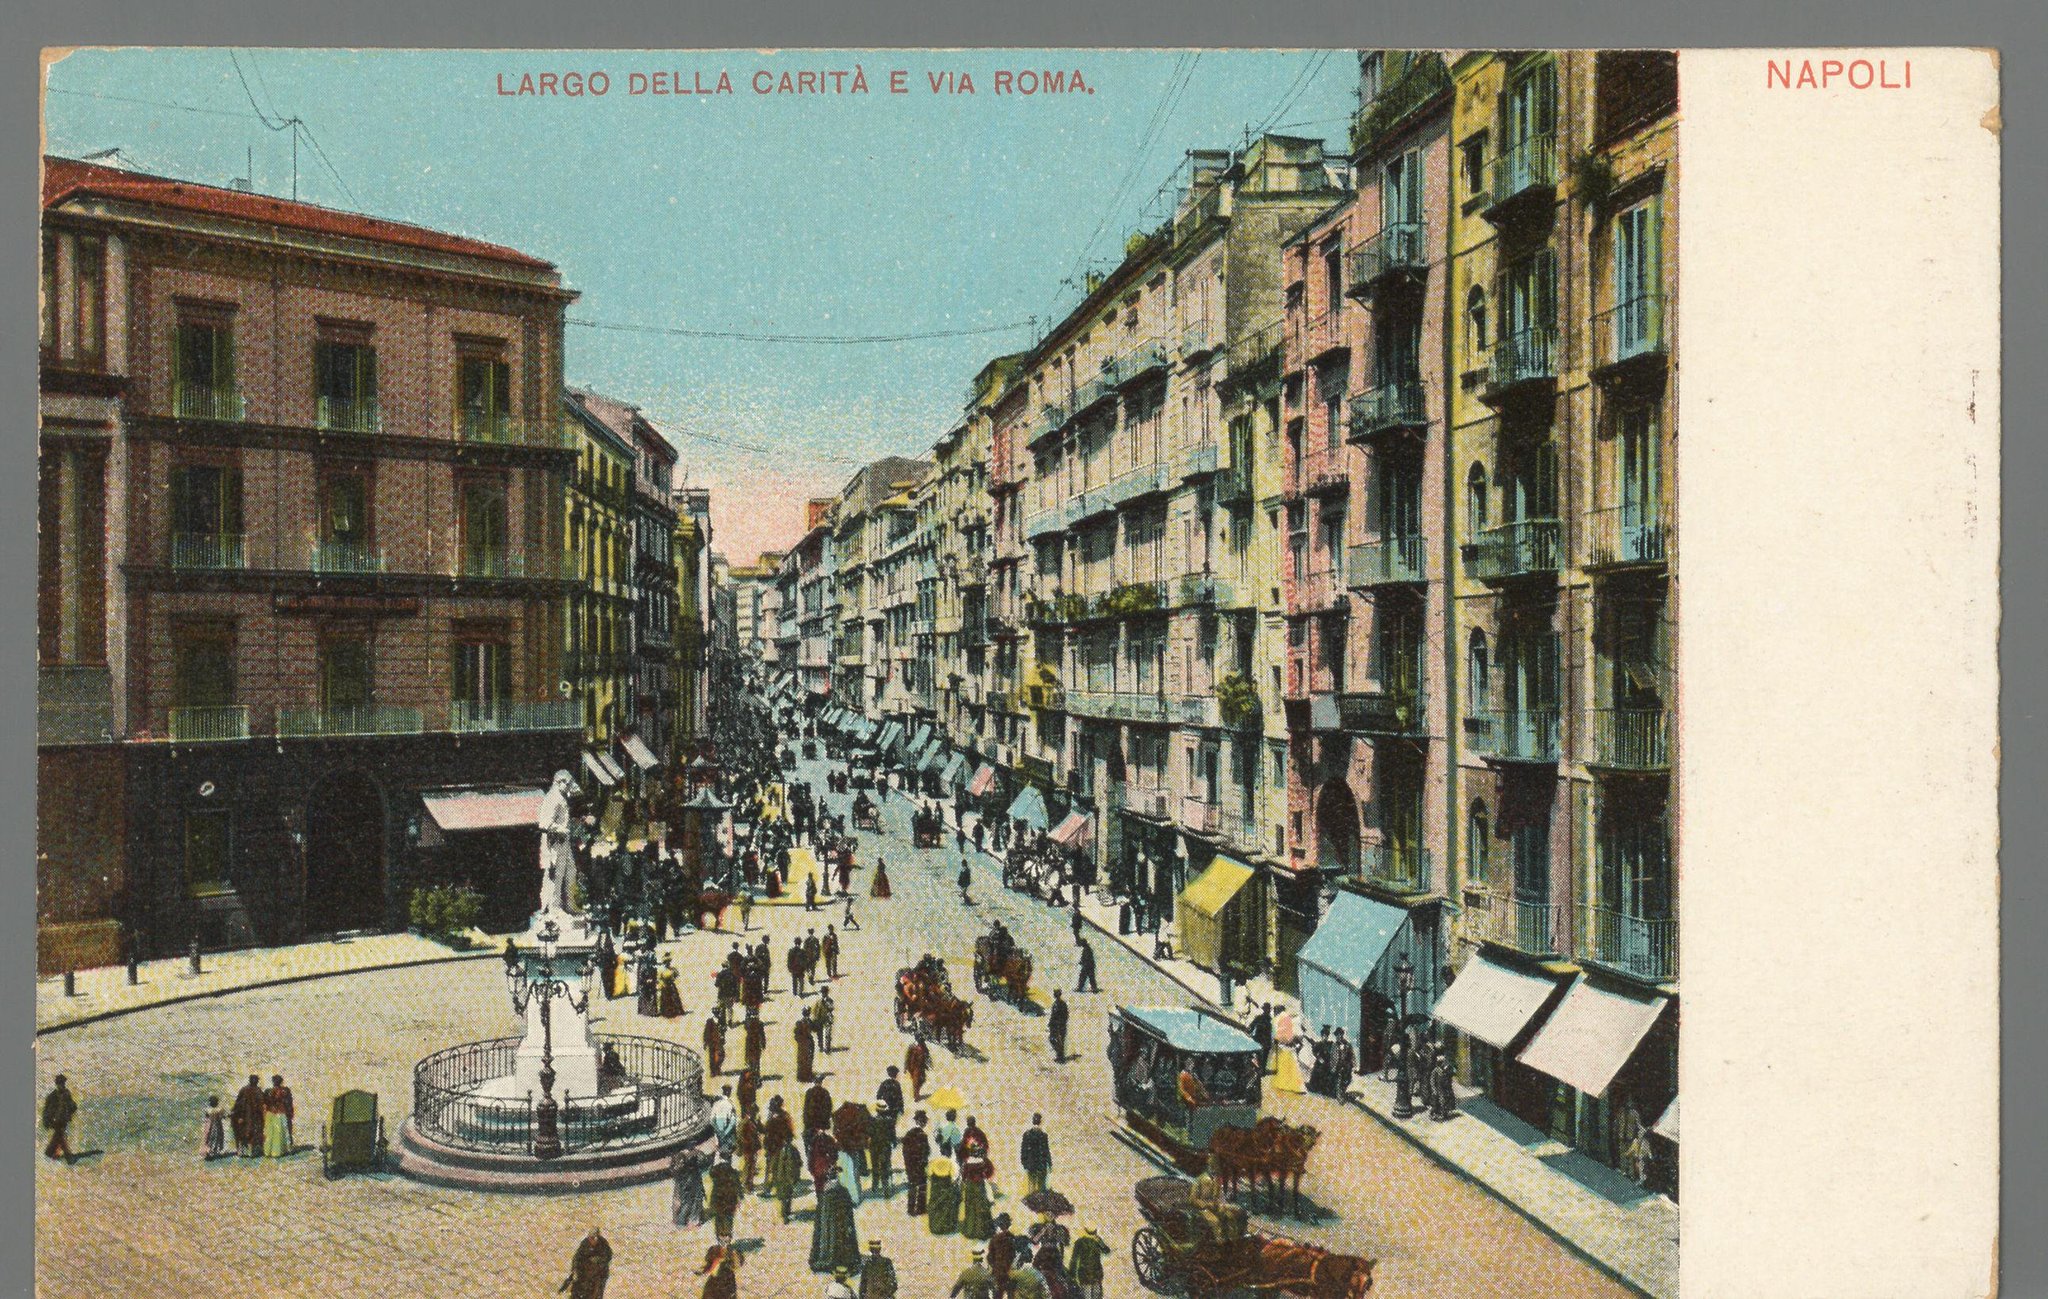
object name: photomechanical print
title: Largo della Carità e Via Roma. Napoli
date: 1906-1930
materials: cardboard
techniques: lithograph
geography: naples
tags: monument, statue, square, place, circus, etc. (+ city(-scape) with figures, staffage), naples